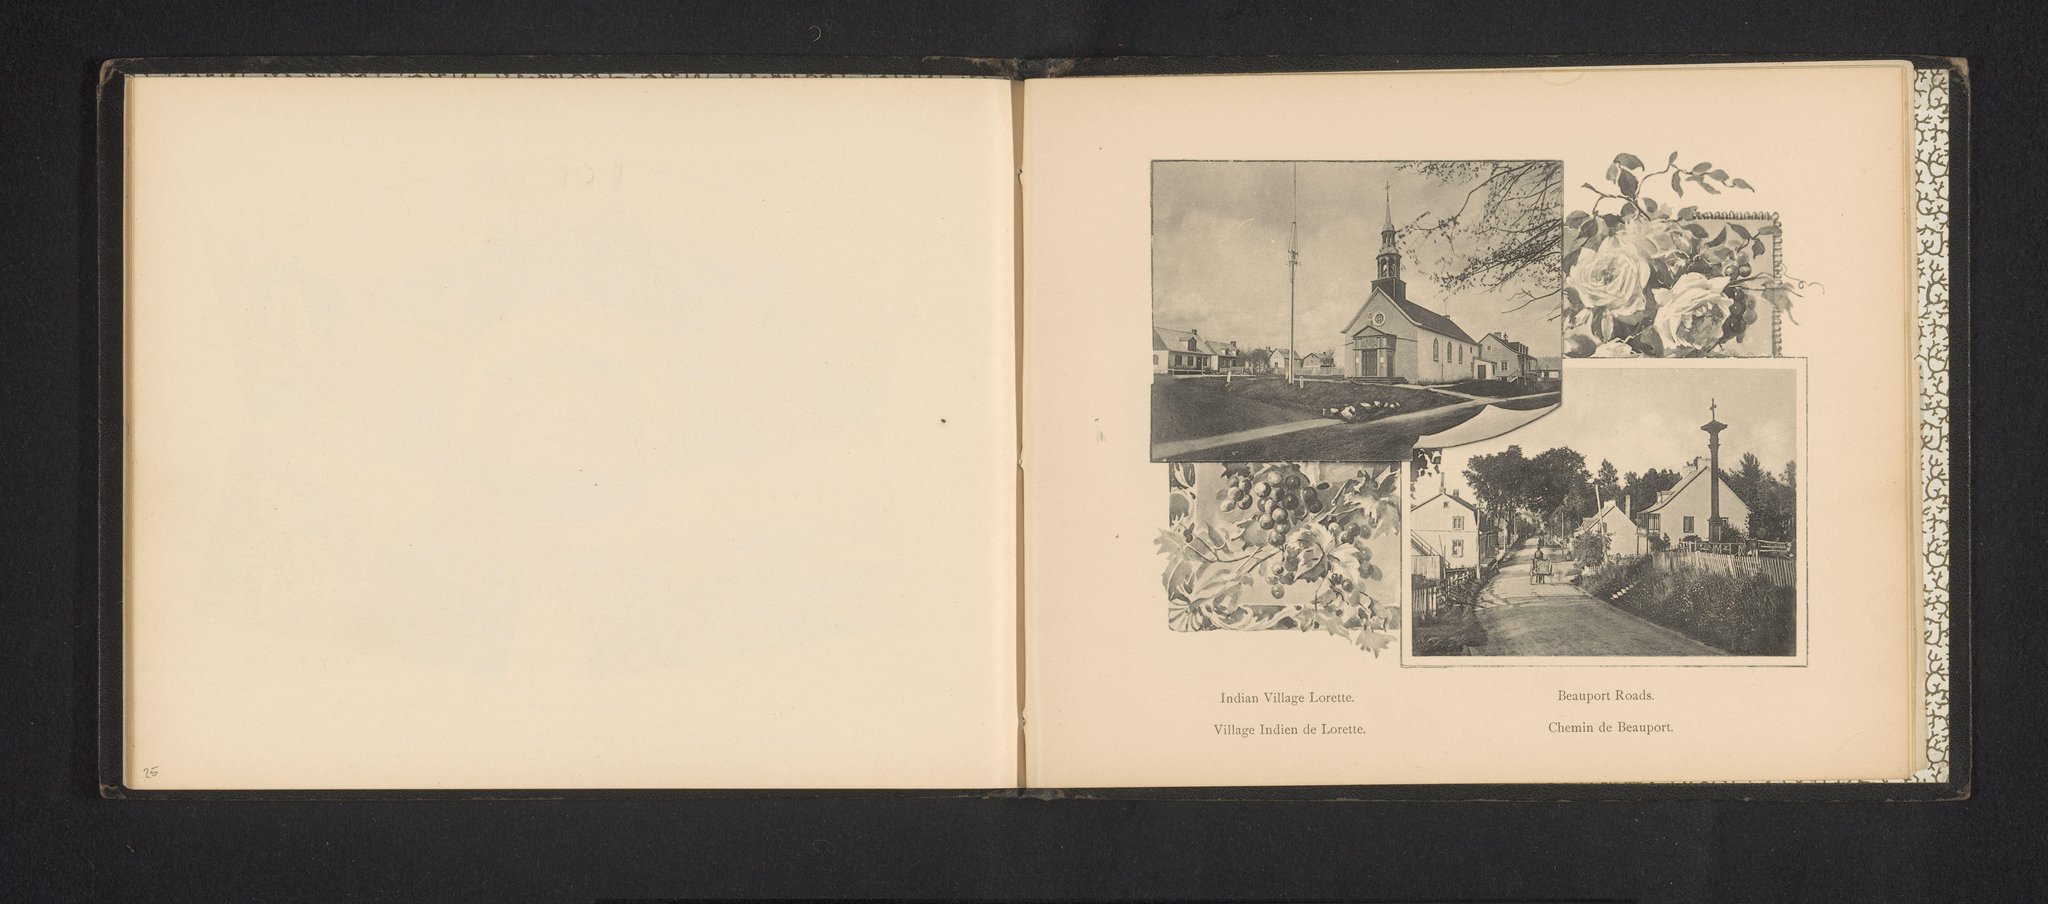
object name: photomechanical print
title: Fotomontage van twee wijken van Québec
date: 1889-1894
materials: paper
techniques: photograph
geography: quebec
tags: city-view in general; 'veduta', church (exterior), street, québec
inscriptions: inscription: ‘Indian Vilalge Lorette/ Beauport Roads’